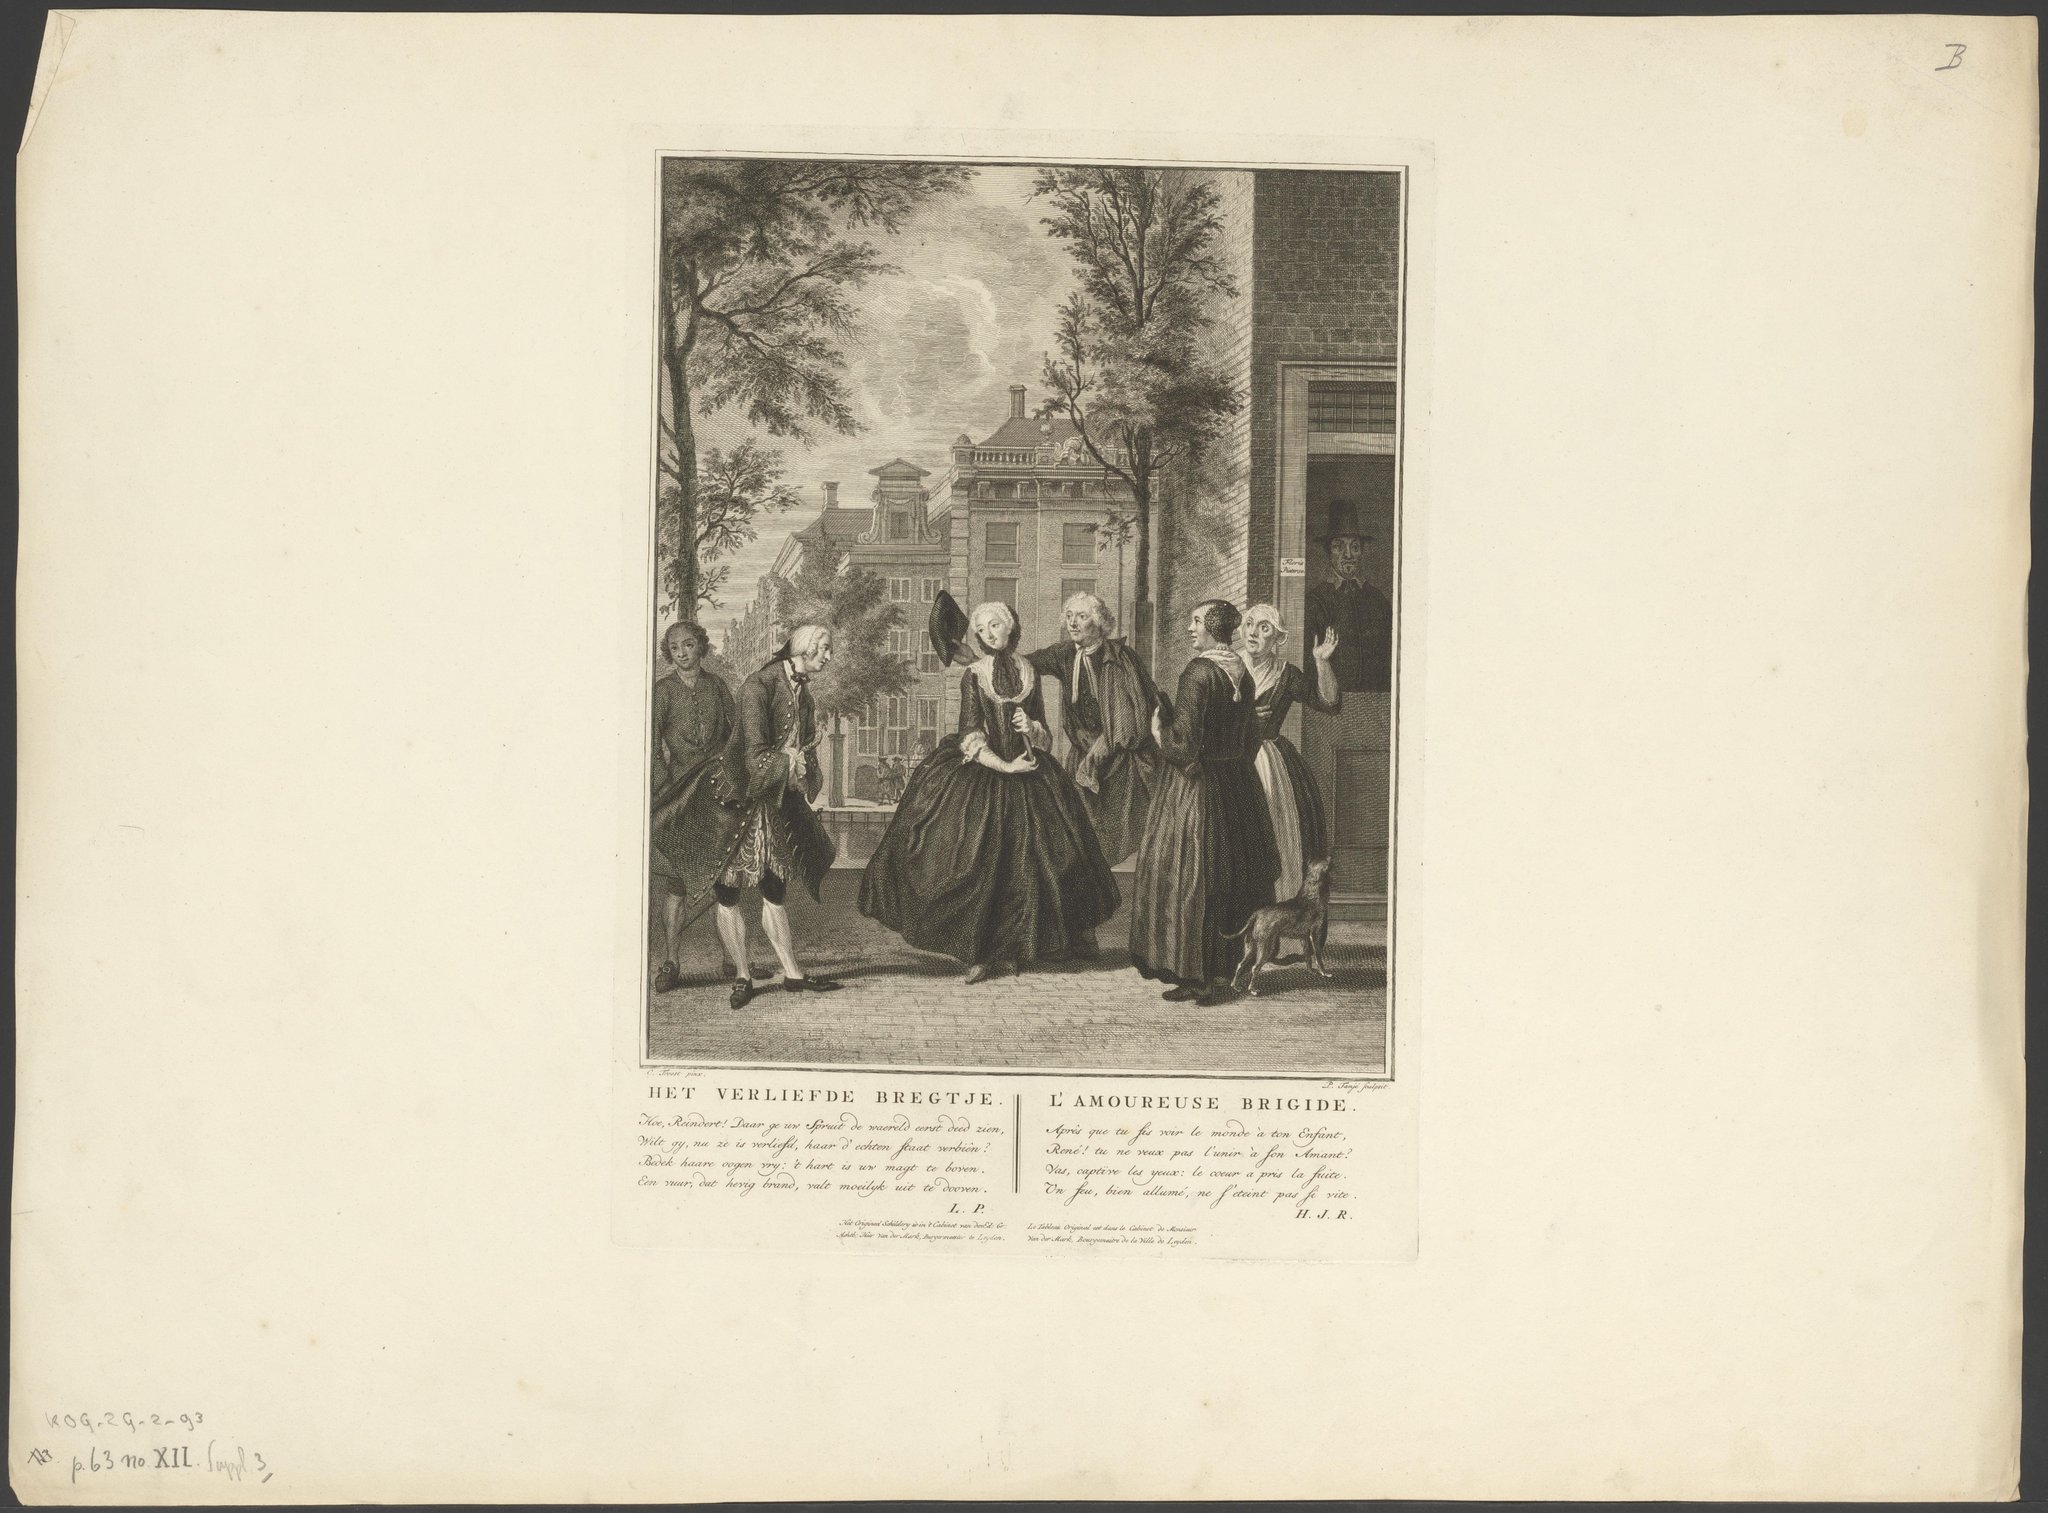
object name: print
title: Het verliefde Bregtje / L'Amoureuse Brigide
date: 1754-1764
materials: paper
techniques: engraving, etching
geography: amsterdam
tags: father and daughter(s) (family group), lovers' meeting, comedy, dog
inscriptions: collector's mark: Lugt 2488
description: Brechje ontmoet op straat haar geliefde Robbertus. Haar vader tracht te verhinderen dat zij hem ziet, door zijn hoed voor haar gezicht te houden. Onderaan in de marge twee vierregelige verzen in het Nederlands en het Frans. Scène uit het toneelstuk Verliefde Brechje, van Pieter Willem Haps.